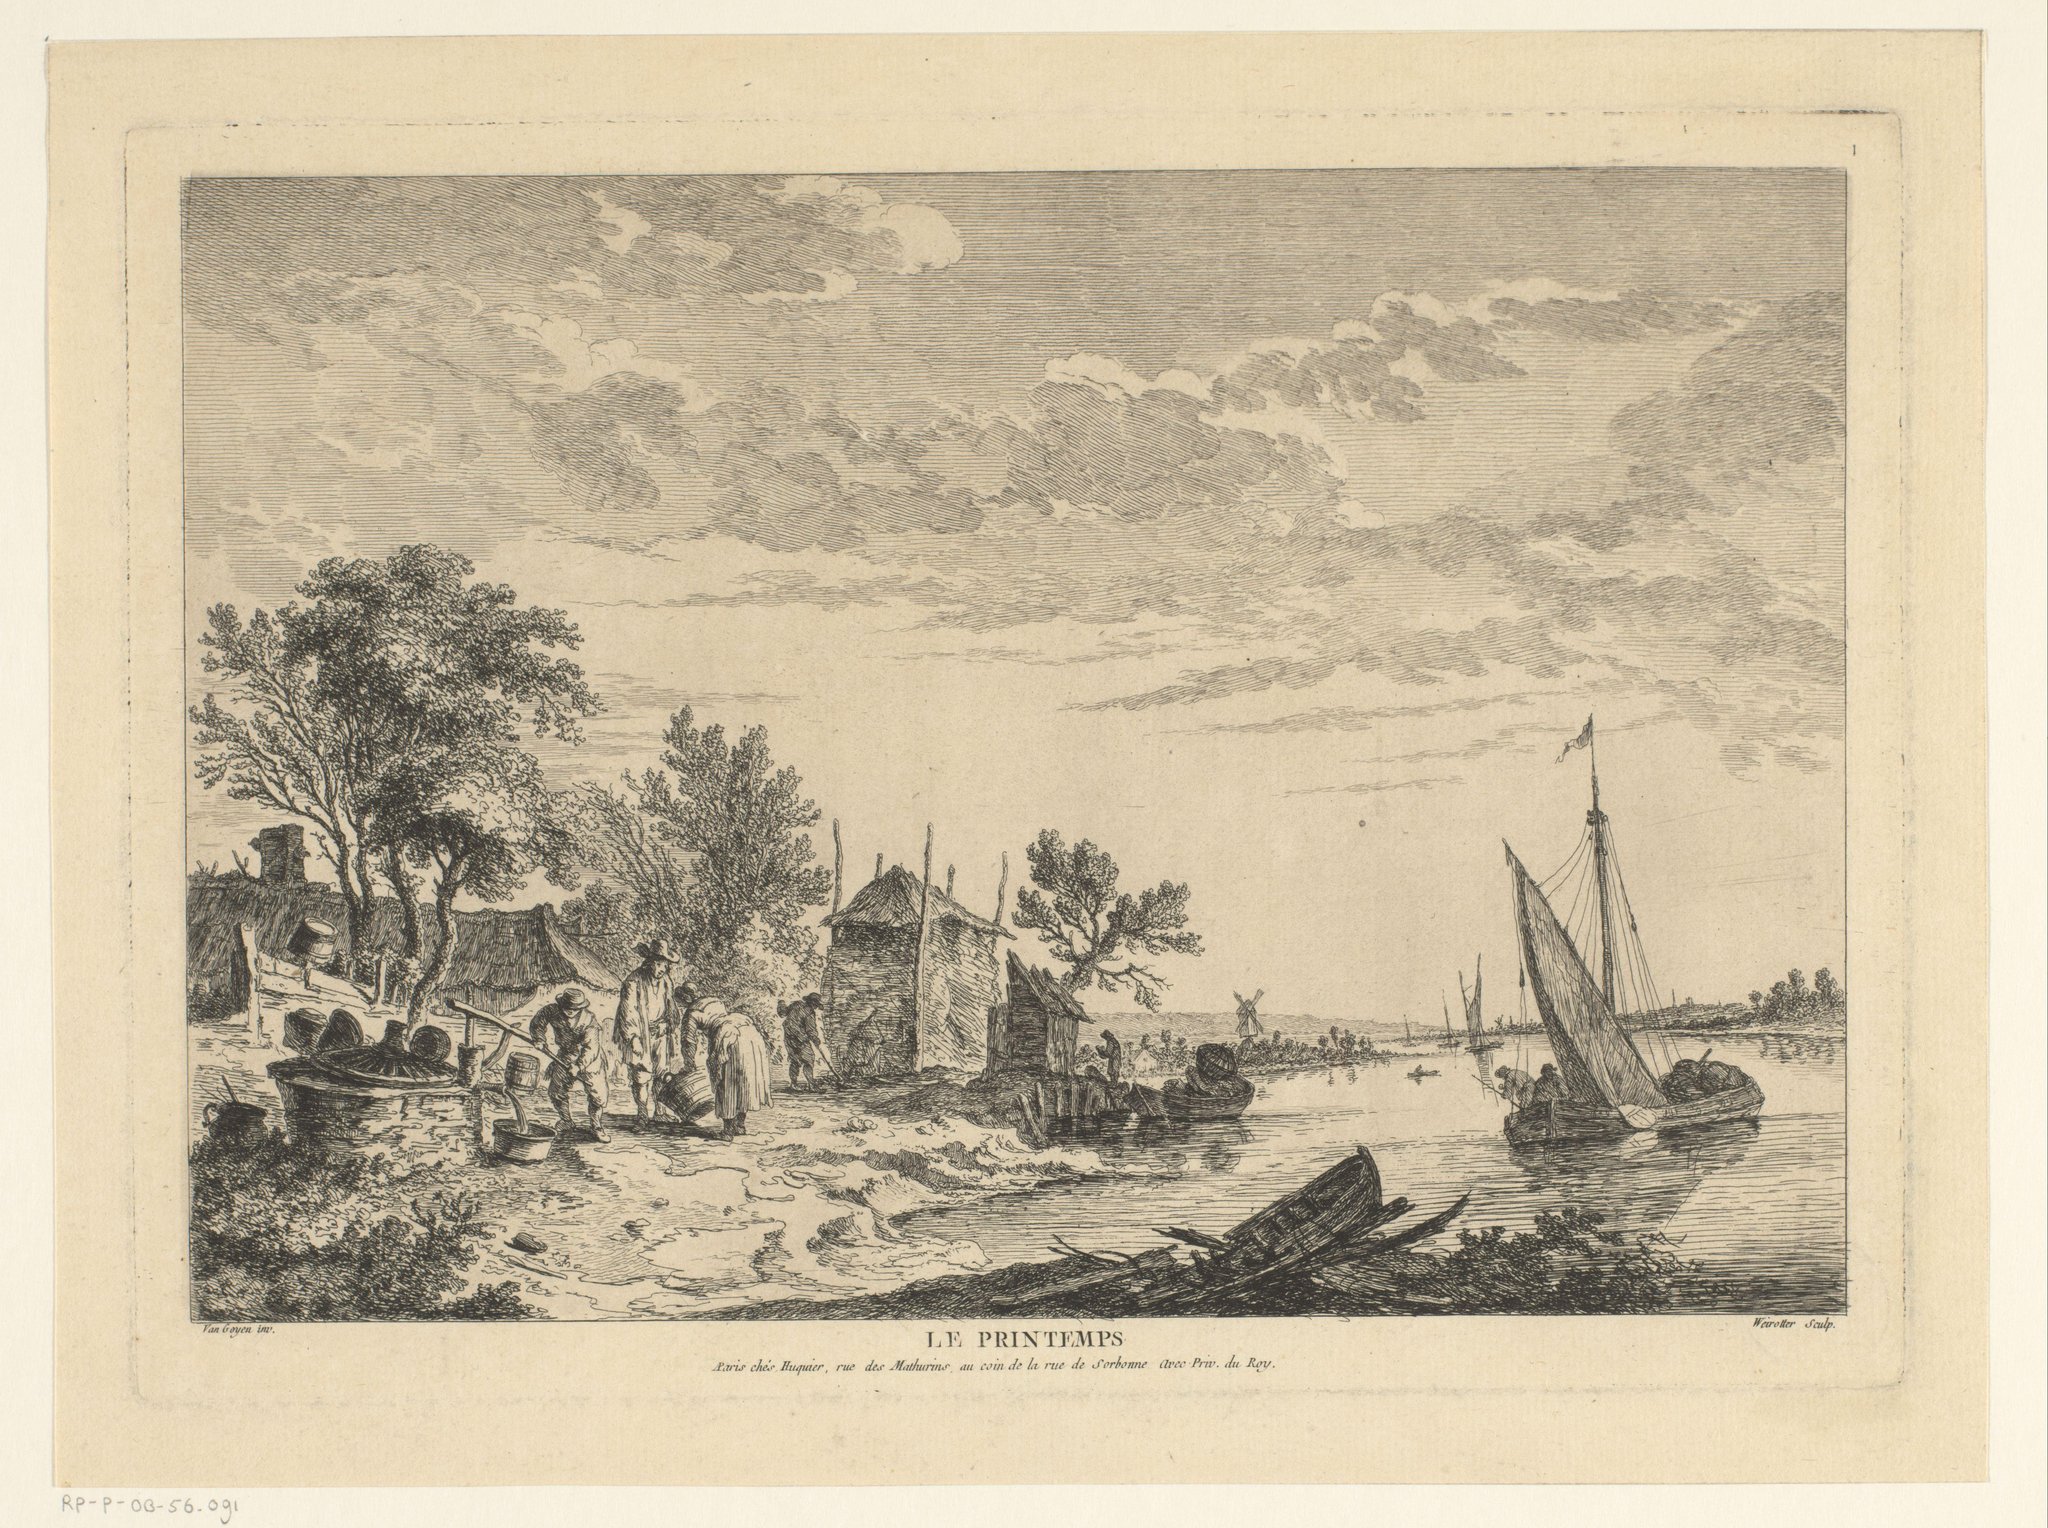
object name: print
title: Lente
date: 1760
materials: paper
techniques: etching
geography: france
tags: well, sailing-ship, sailing-boat, river, spring ~ human activities (the four seasons of the year), farm or solitary house in landscape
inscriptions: collector's mark: Lugt 240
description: Prent maakt deel uit van een serie van vier prenten met de vier seizoenen.